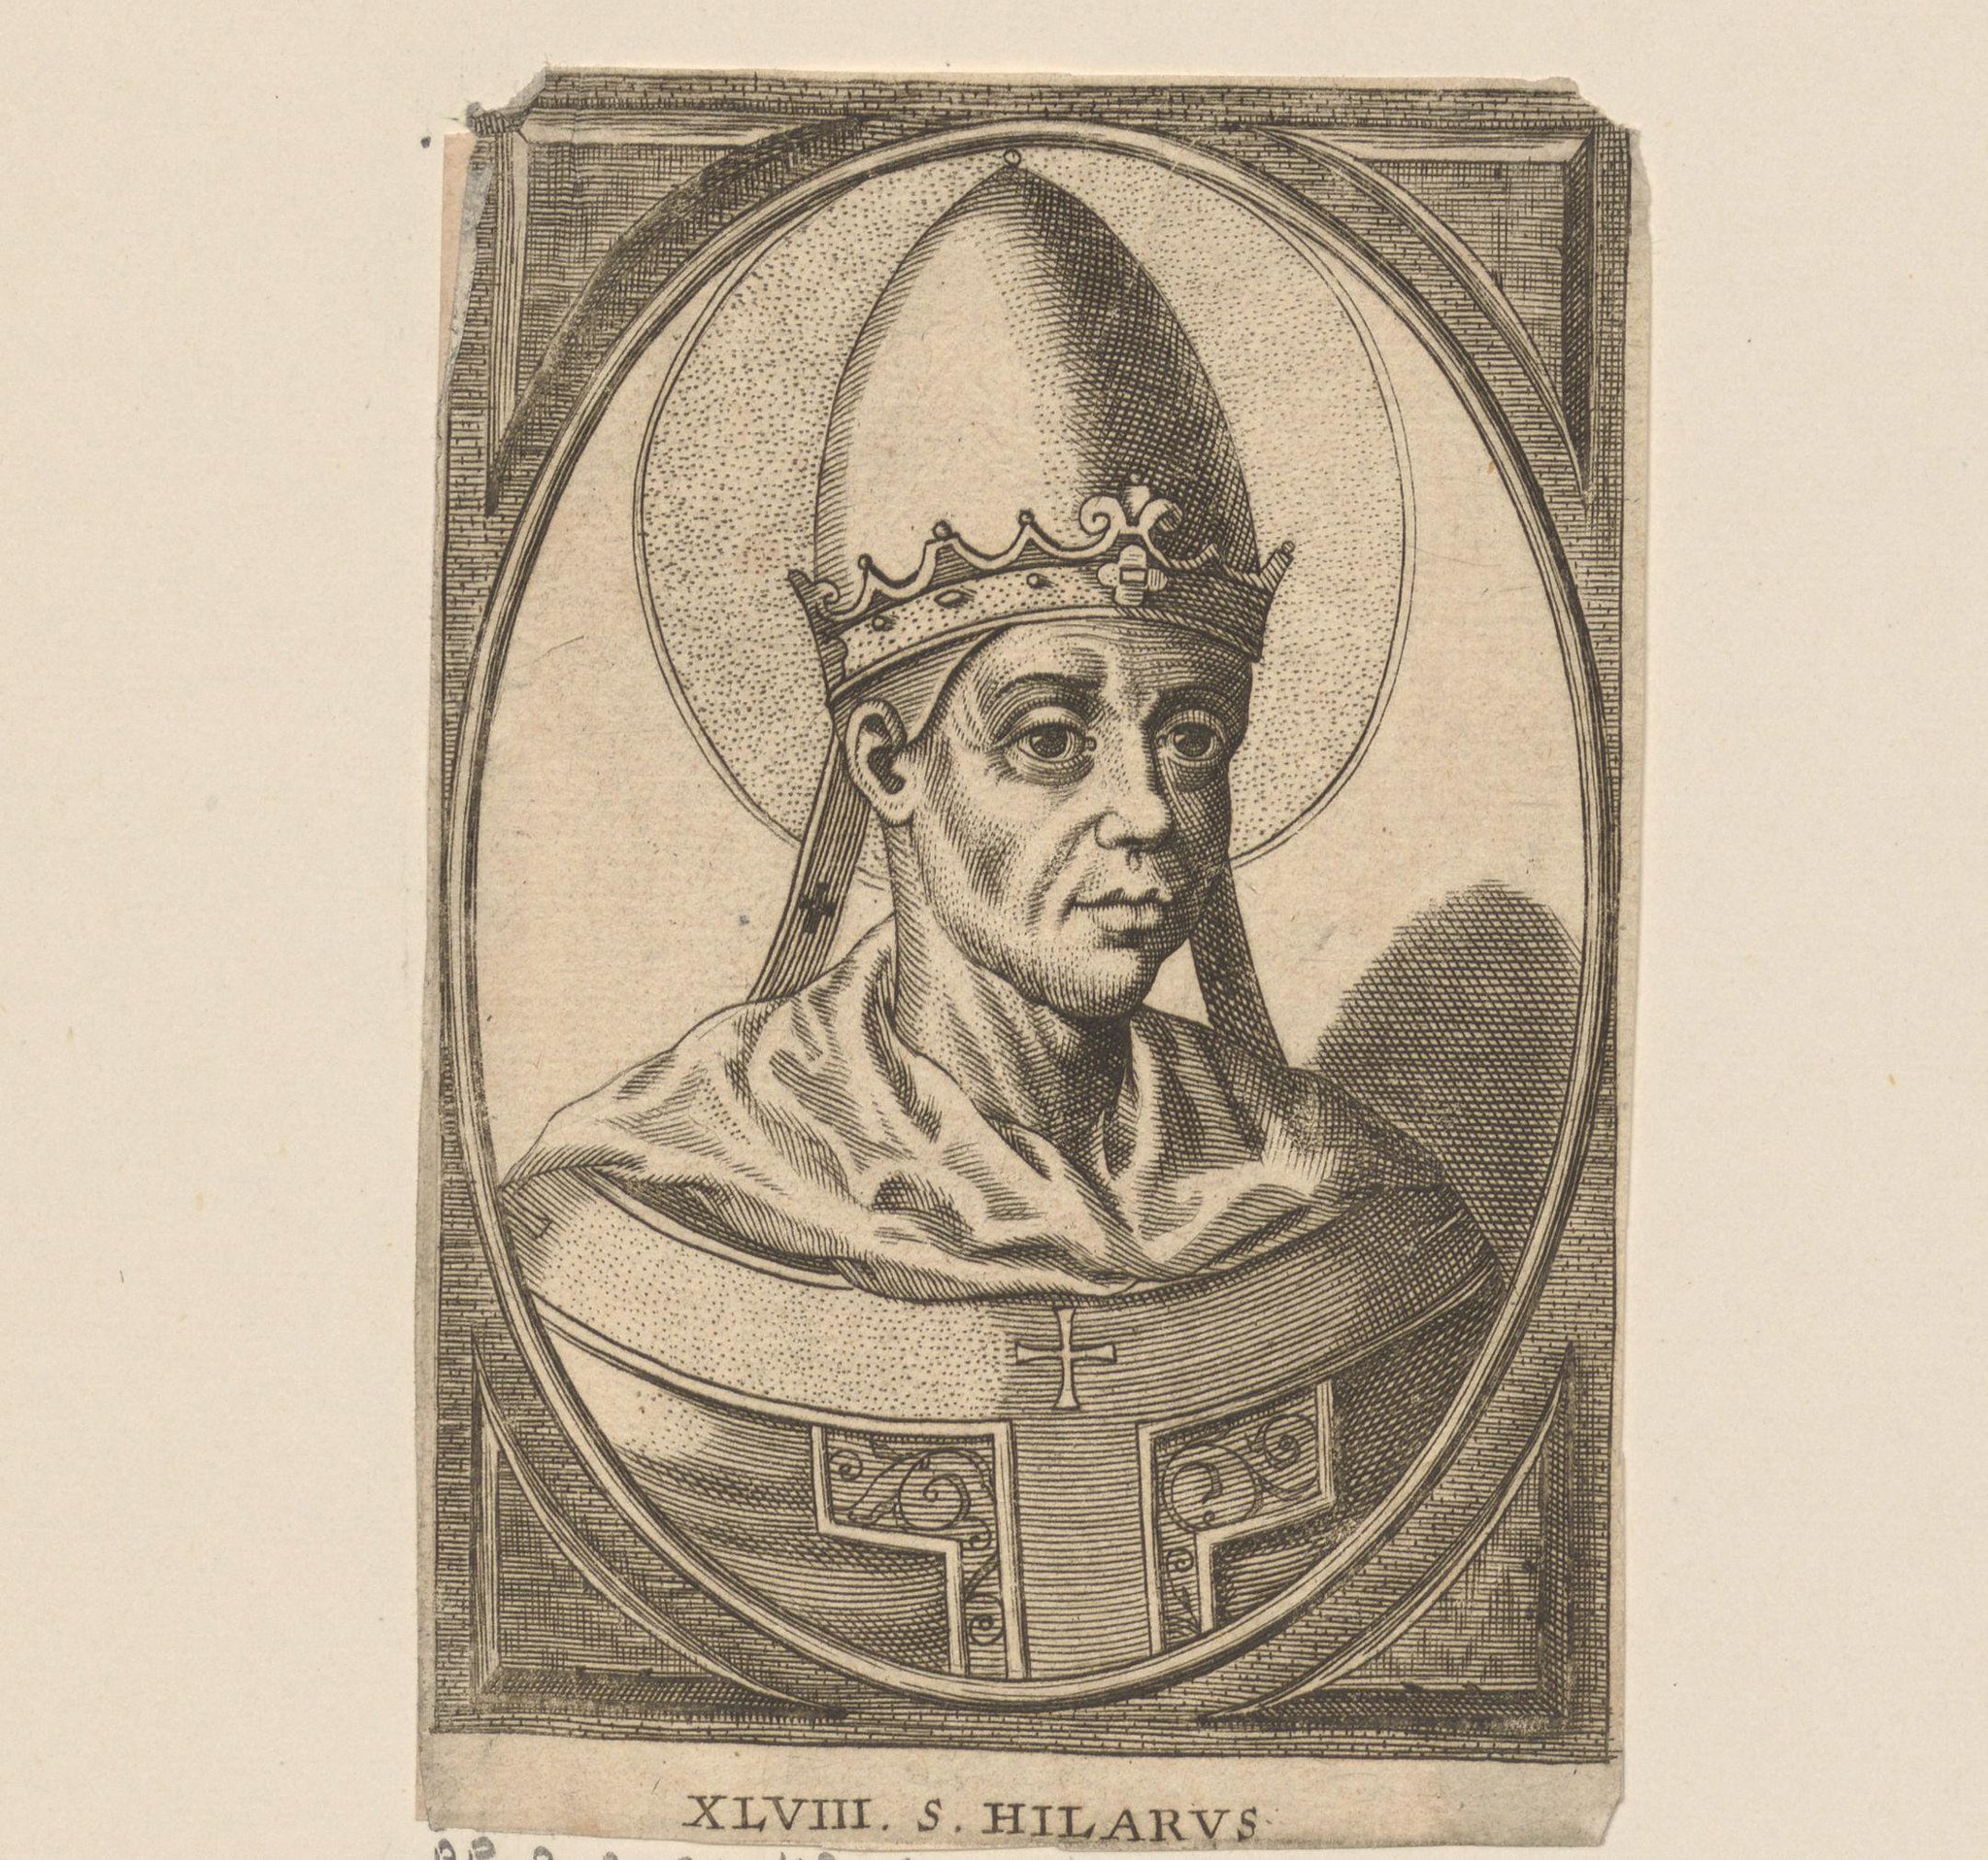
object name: print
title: Portret van paus Hilarius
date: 1678-1685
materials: paper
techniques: engraving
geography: antwerp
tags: rome, historical persons, pope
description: Prent gebruikt in: Hazart, Cornelis. Triomph der pausen van Roomen over alle hare benyders ende bestryders (...). Antwerpen: Michiel Cnobbaert, 1678. Ook gebruikt in: Papenbroeck, Daniel van. Conatus chronico-historicus ad catalogum romanorum pontificum. Antwerpen: Michiel Cnobbaert, 1685. En in: Propylaeum ad acta sanctorum maii (...). Antwerpen: Michiel Cnobbaert, s.a.